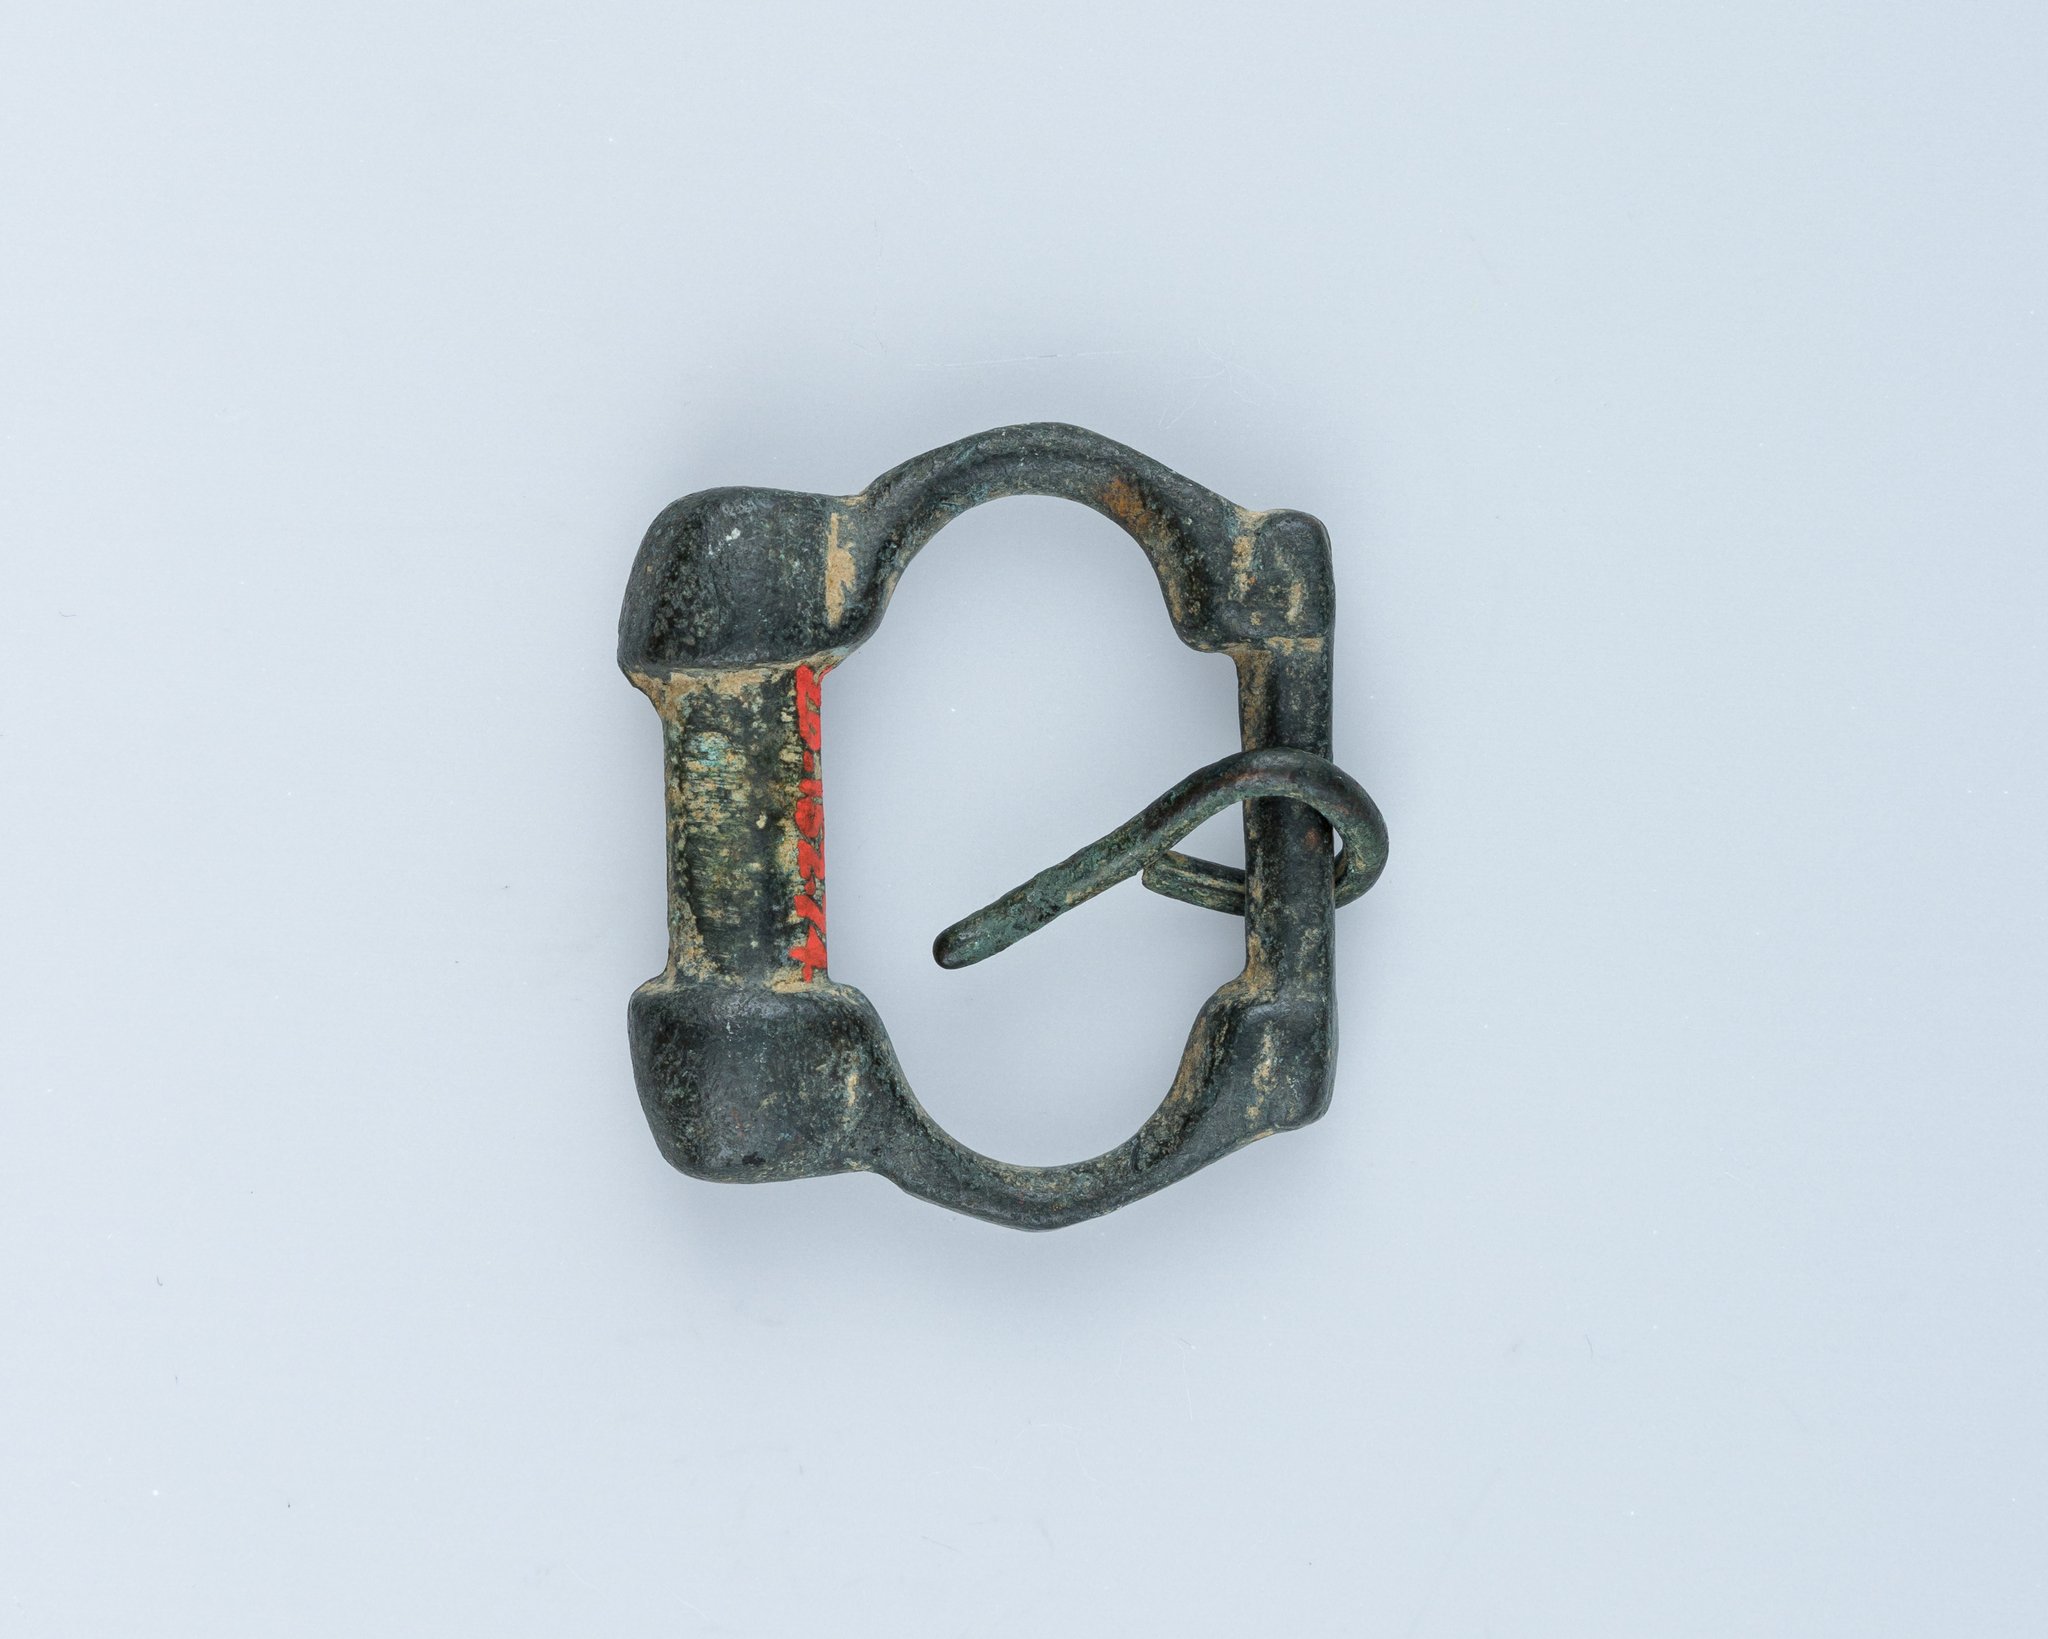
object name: buckle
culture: french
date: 1301-1400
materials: bronze, patina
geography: france